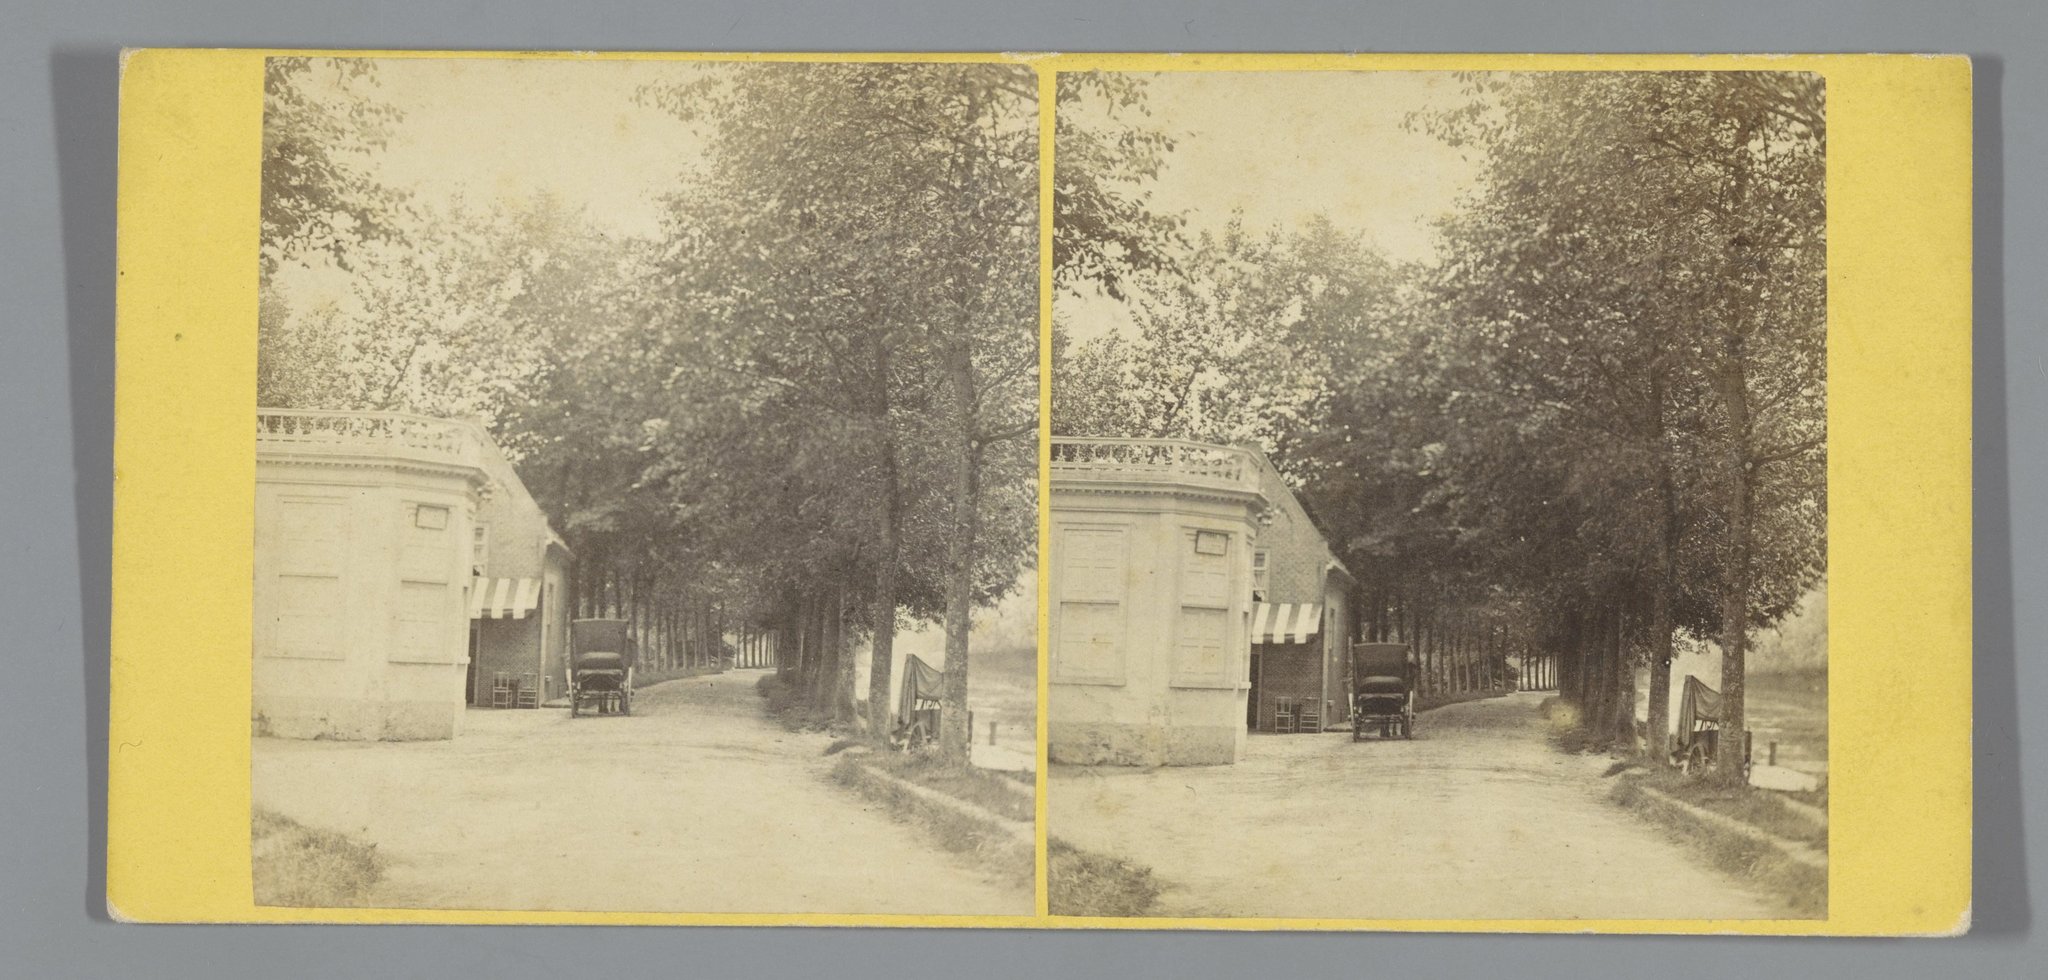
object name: stereograph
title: Gezicht op de Delftse vaart bij de Hoornbrug bij Den Haag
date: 1860-1885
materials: cardboard, photographic support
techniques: albumen print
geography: amsterdam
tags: bridge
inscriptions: inscription: ‘No. 71./ DE DELFTSCHE VAART/ BIJ/ de Hoornbrug./ A. JAGER, WATER 110, TE AMSTERDAM.’